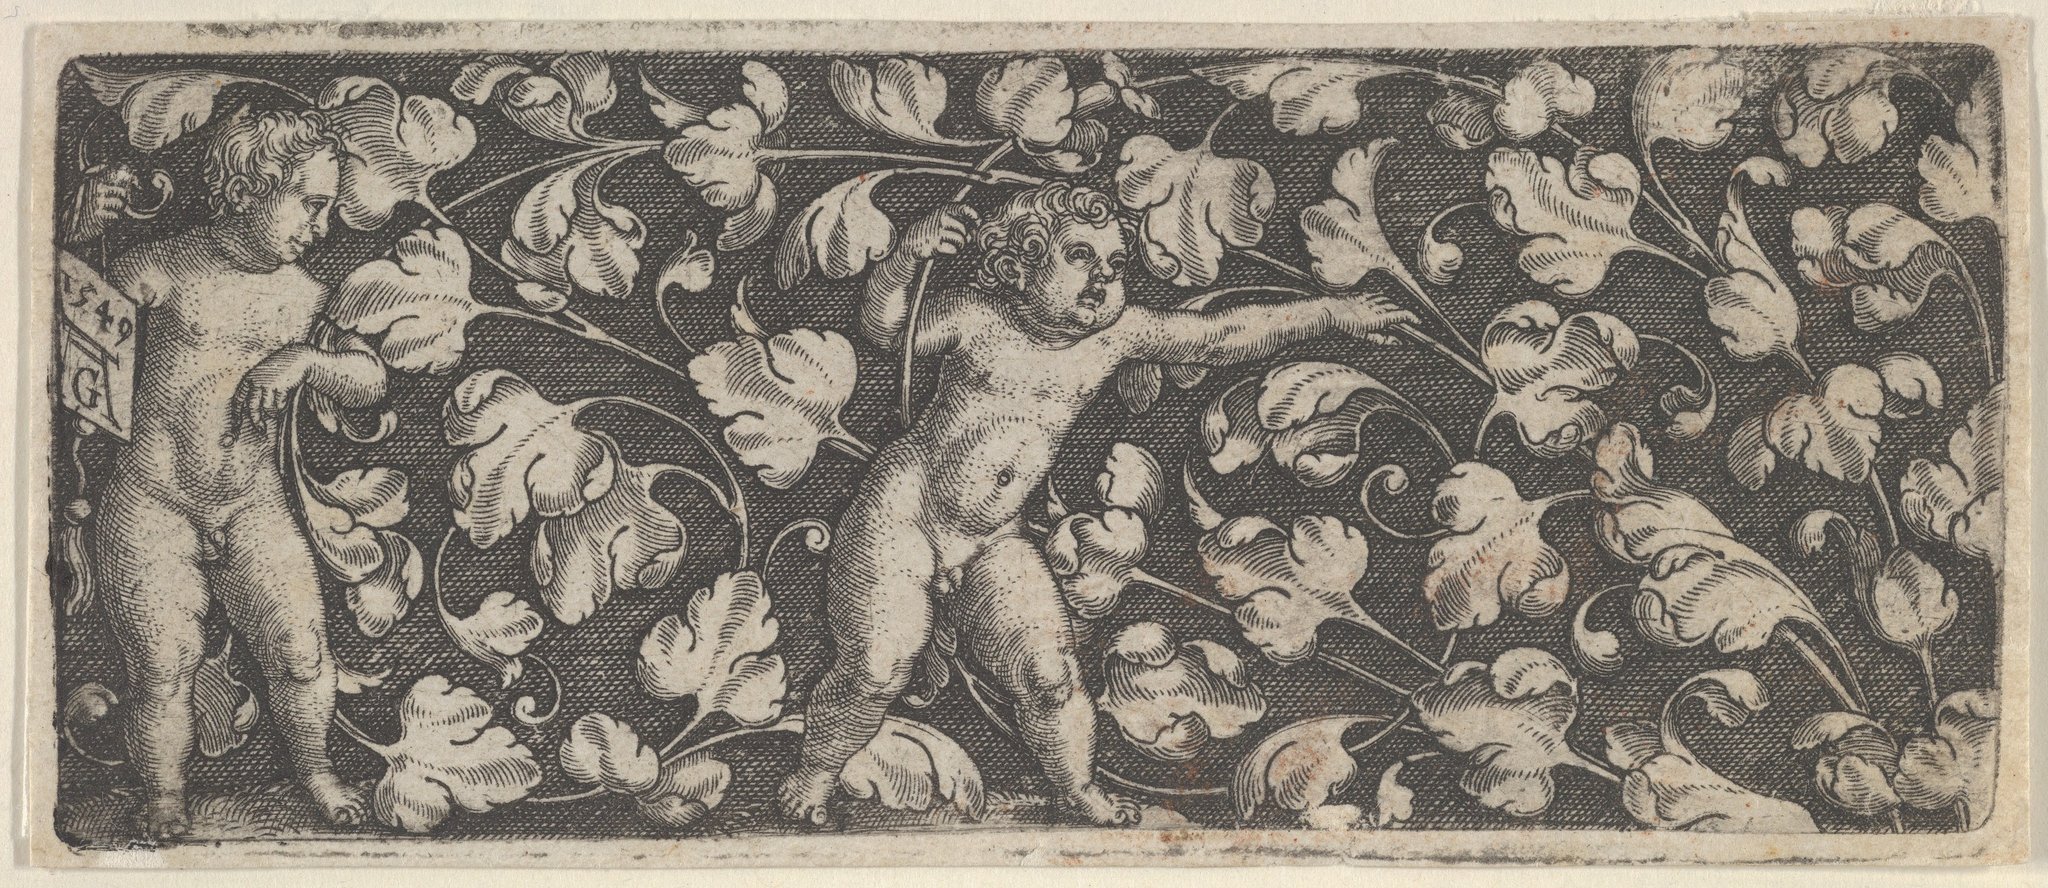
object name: print ornament architecture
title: Horizontal Panel with Two Nude Boys Surrounded by Tendrils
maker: heinrich aldegrever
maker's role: artist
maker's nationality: german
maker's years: 1502-1561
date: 1549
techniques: engraving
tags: male nudes,leaves